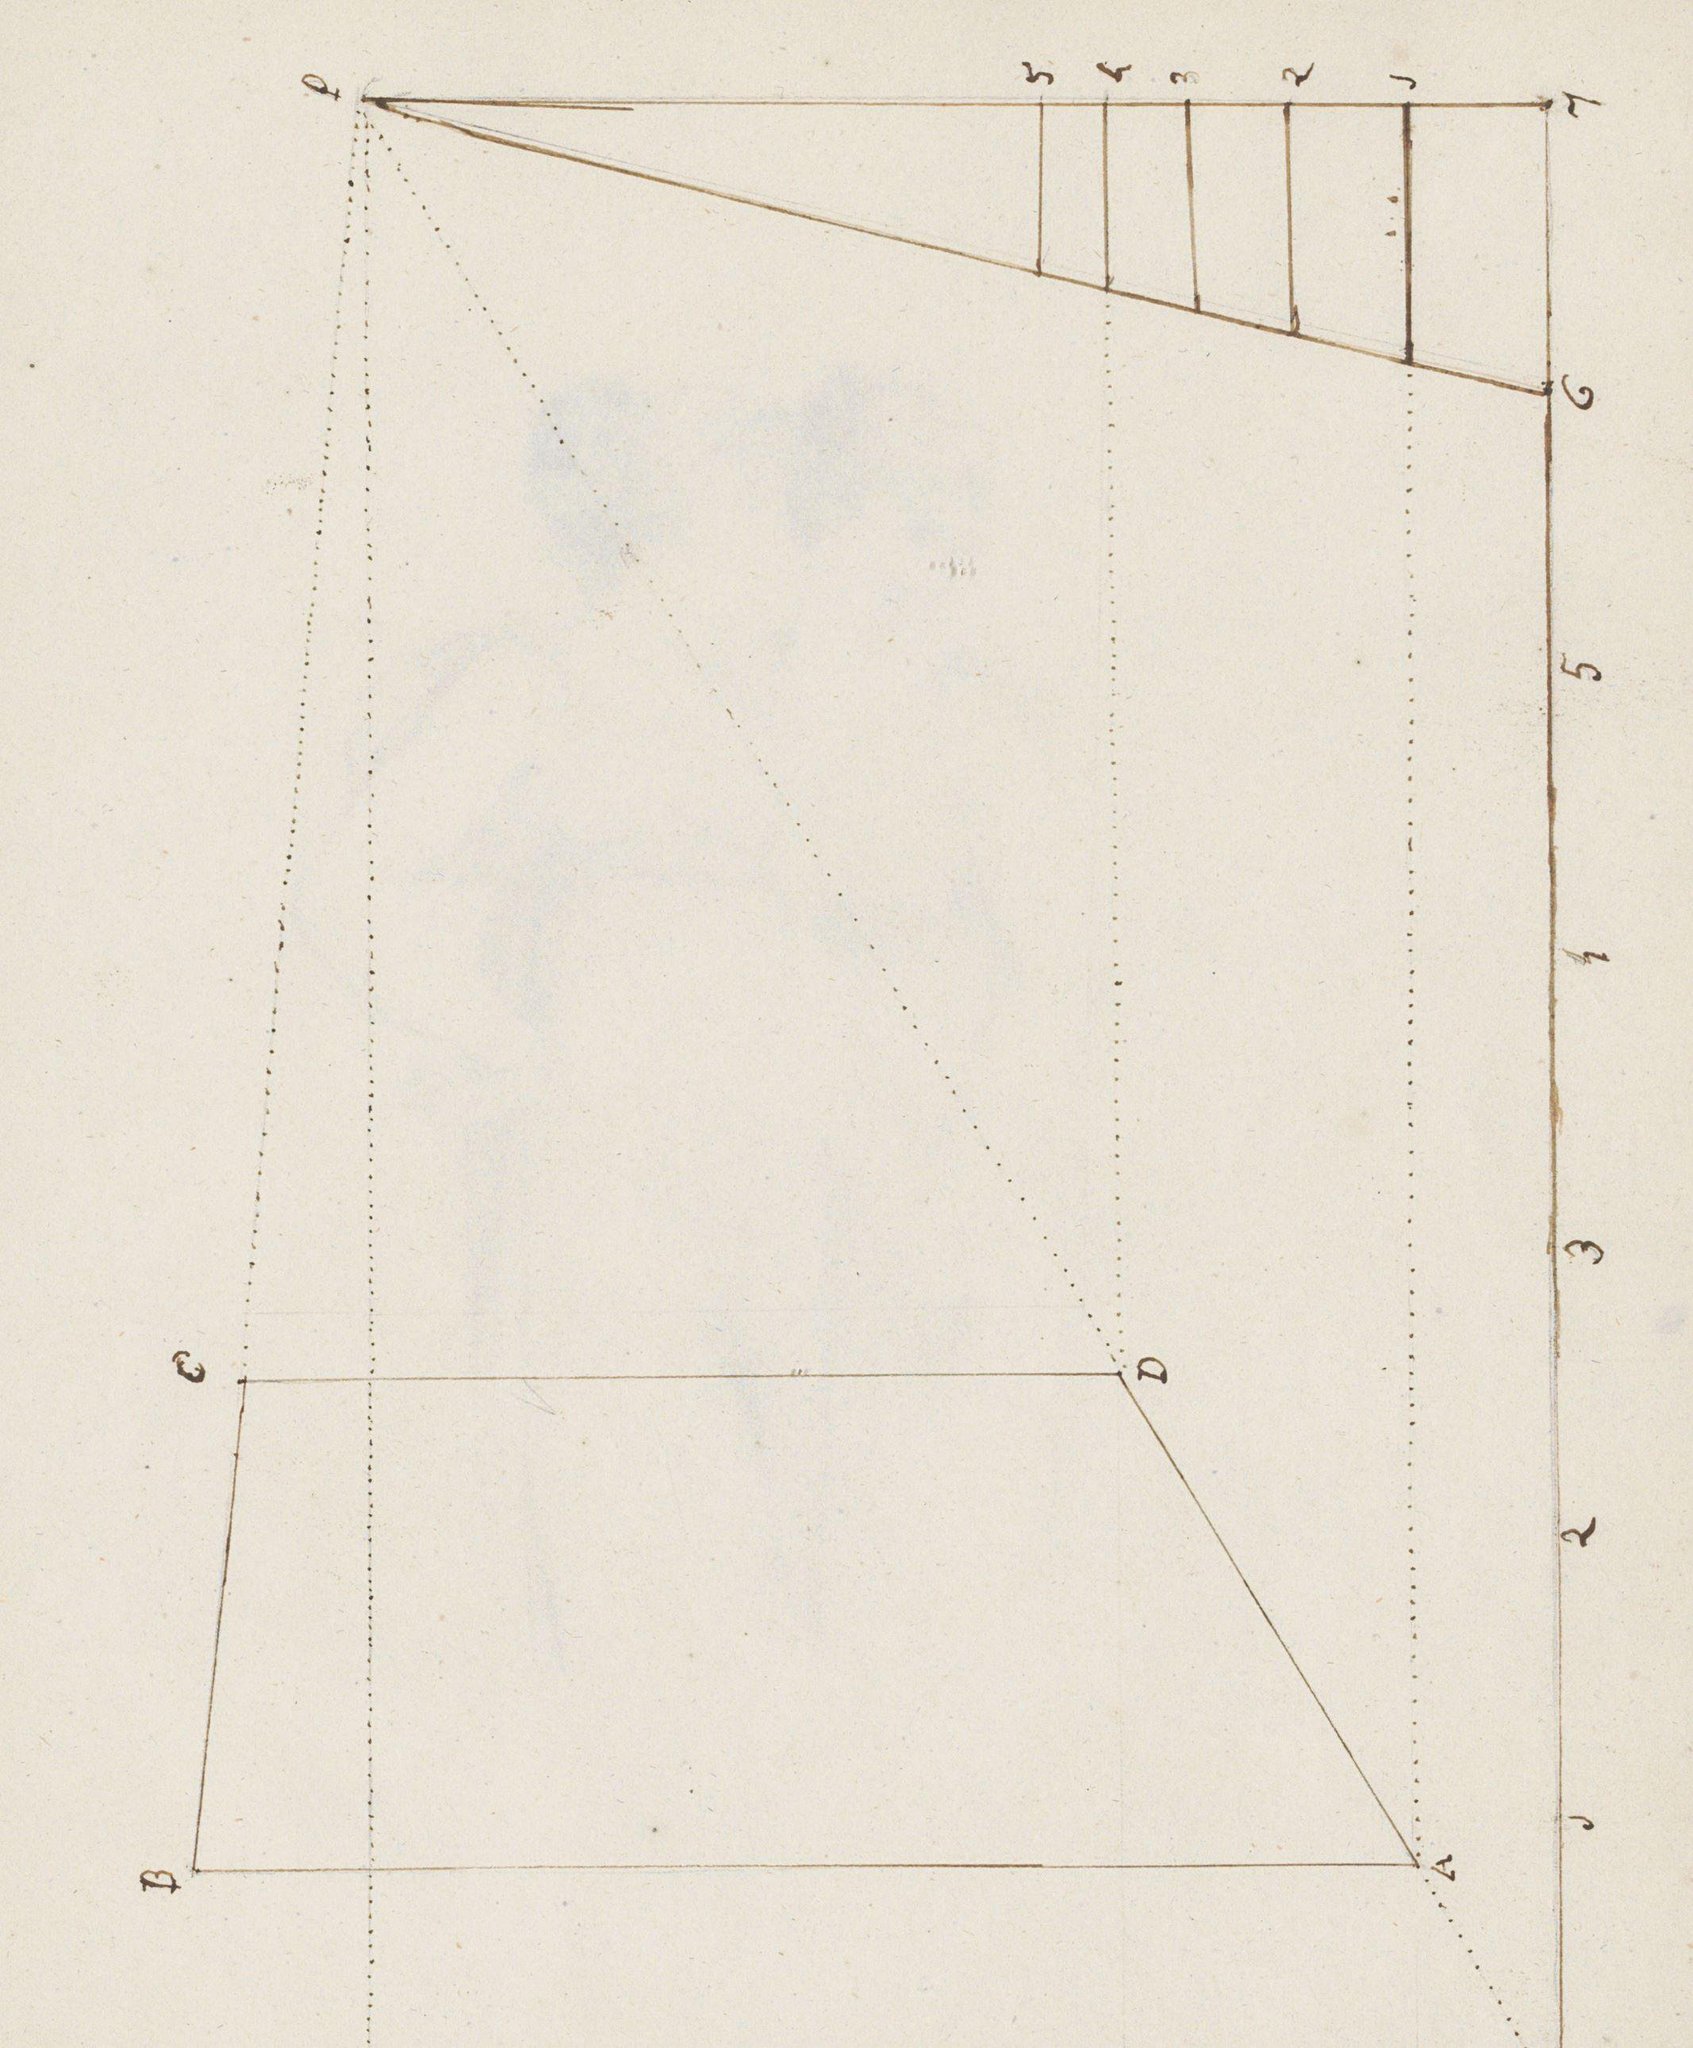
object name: sketchbook leaf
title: Perspectiefoefening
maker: jonkvrouw catharina kemper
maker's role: draughtsman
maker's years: 1801-1871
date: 1813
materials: ink, paper, pencil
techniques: pen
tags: mathematical perspective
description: Blad 11 recto uit een schetsboek met 91 bladen.